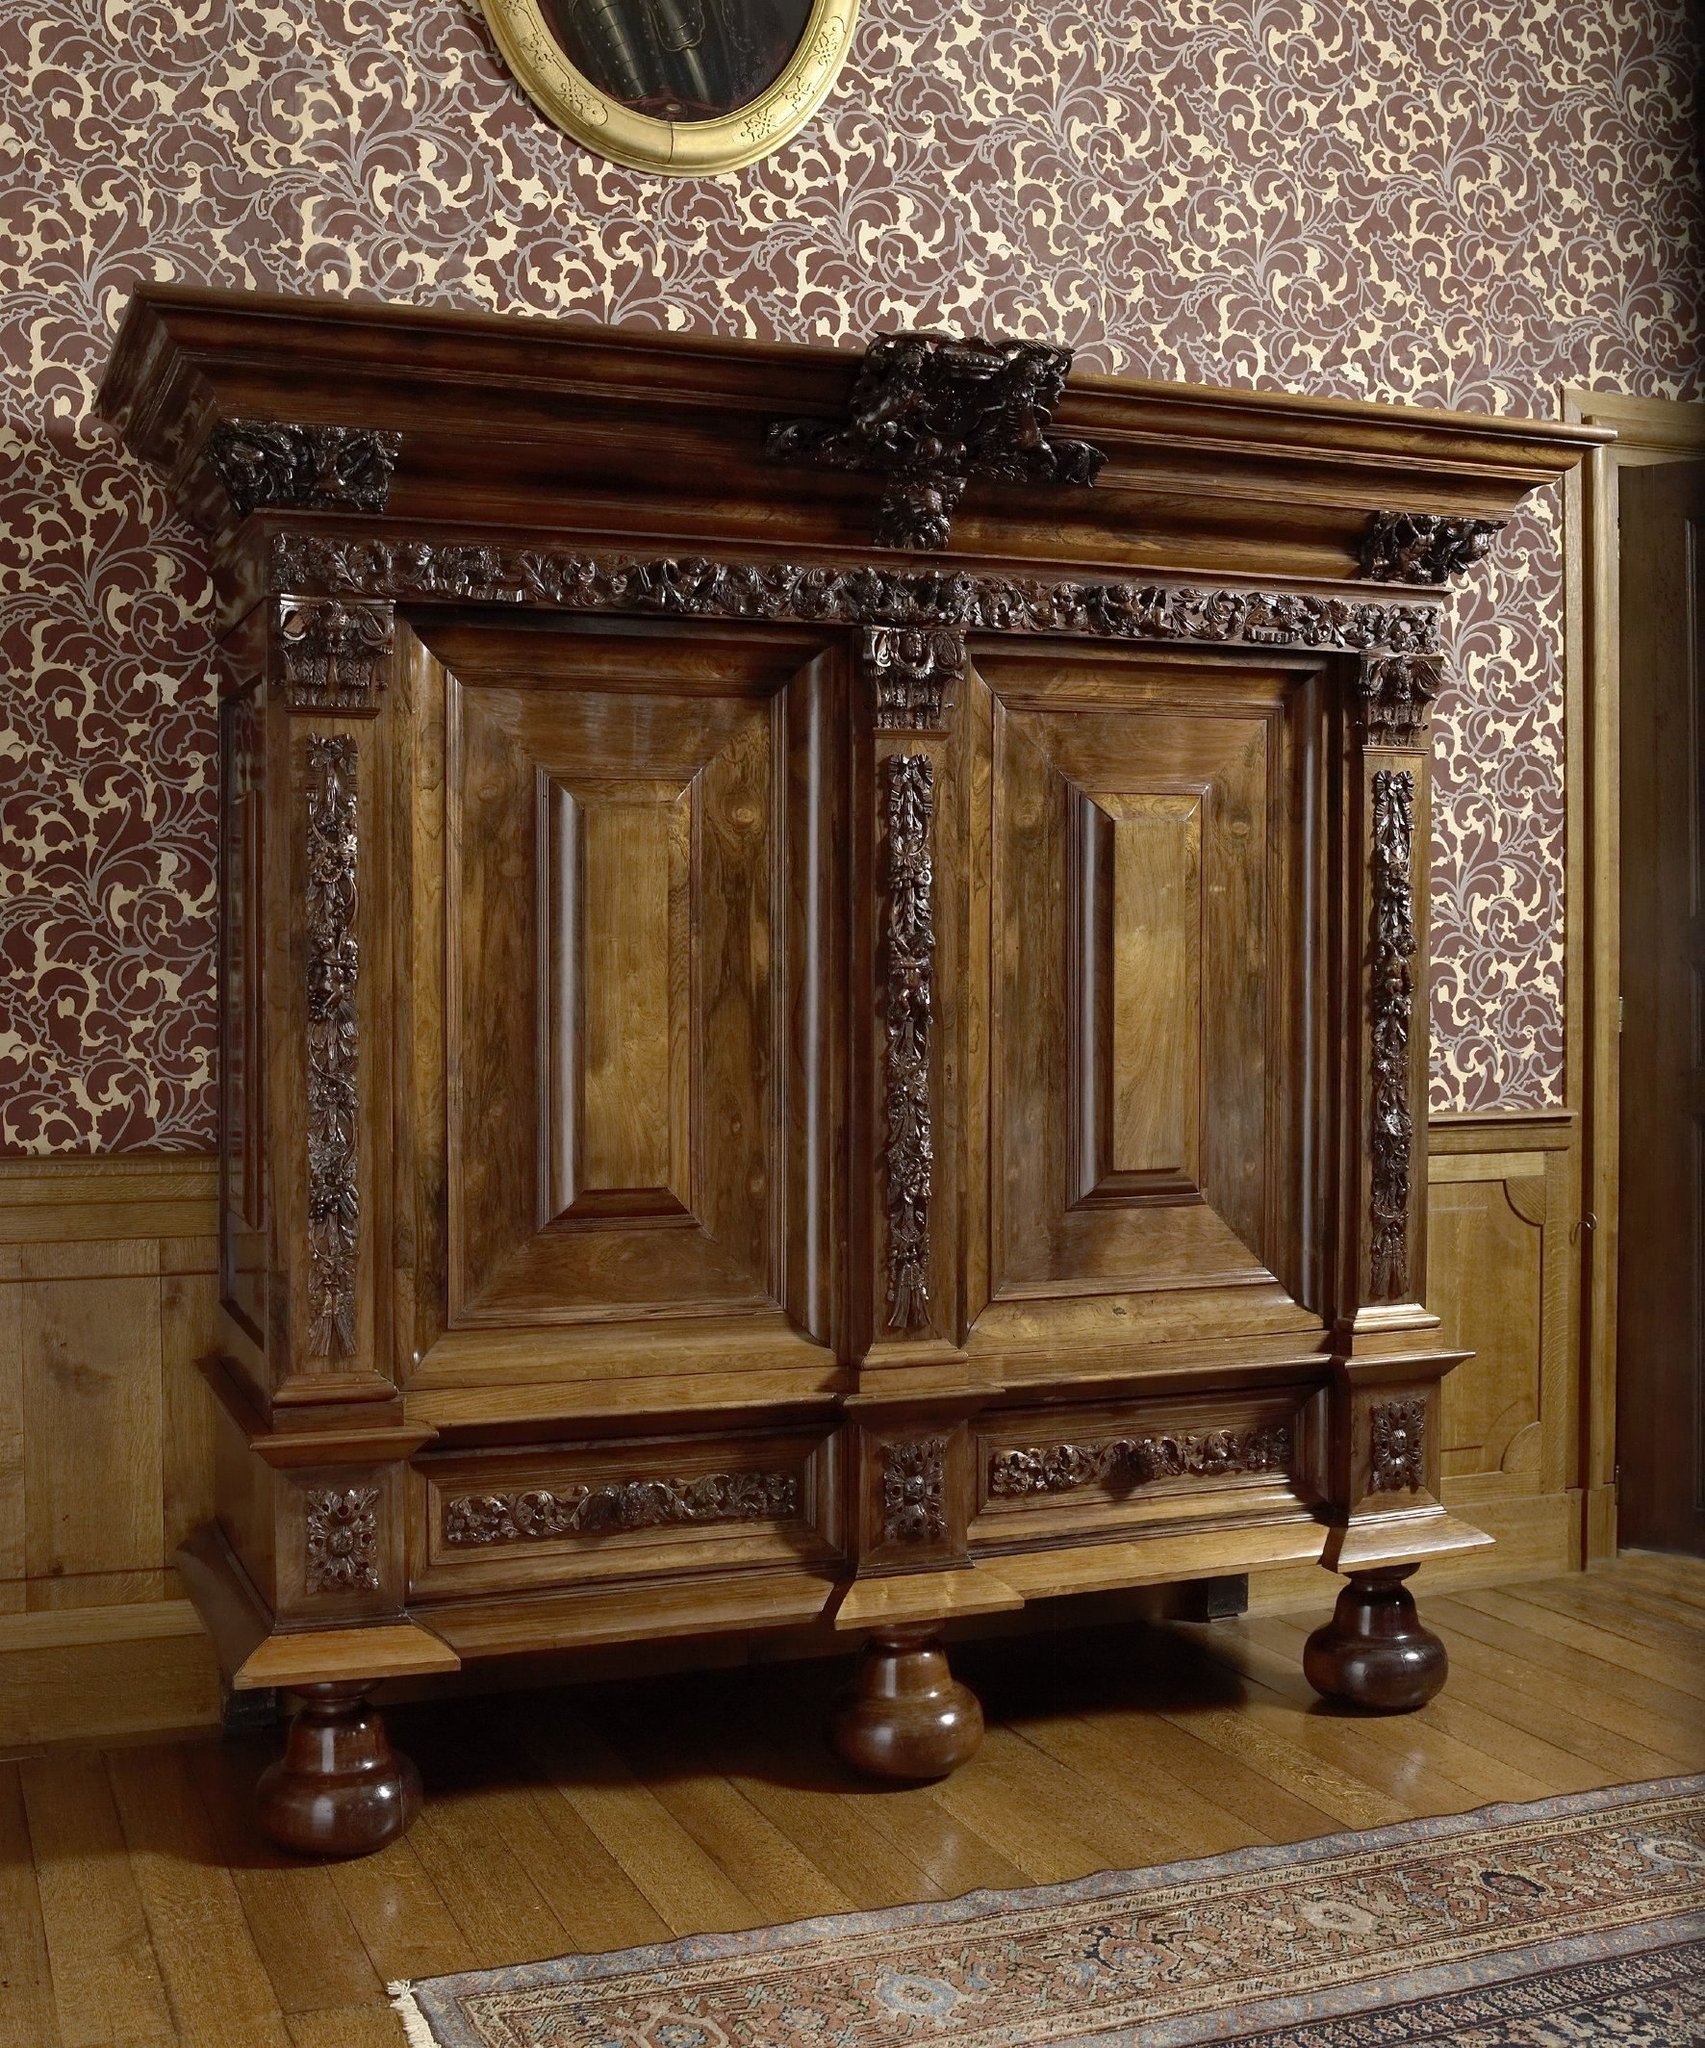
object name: case furniture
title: Kast met het wapen Alberda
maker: Anonymous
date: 1689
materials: wood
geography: netherlands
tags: uithuizen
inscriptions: date: ‘ANNO 1689’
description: Cupboard. Oak, veneered with rosewood. On the cornice, the arms of Mello Alberda. From Menkemaborg (Groningen) Northern Netherlands, 1689.